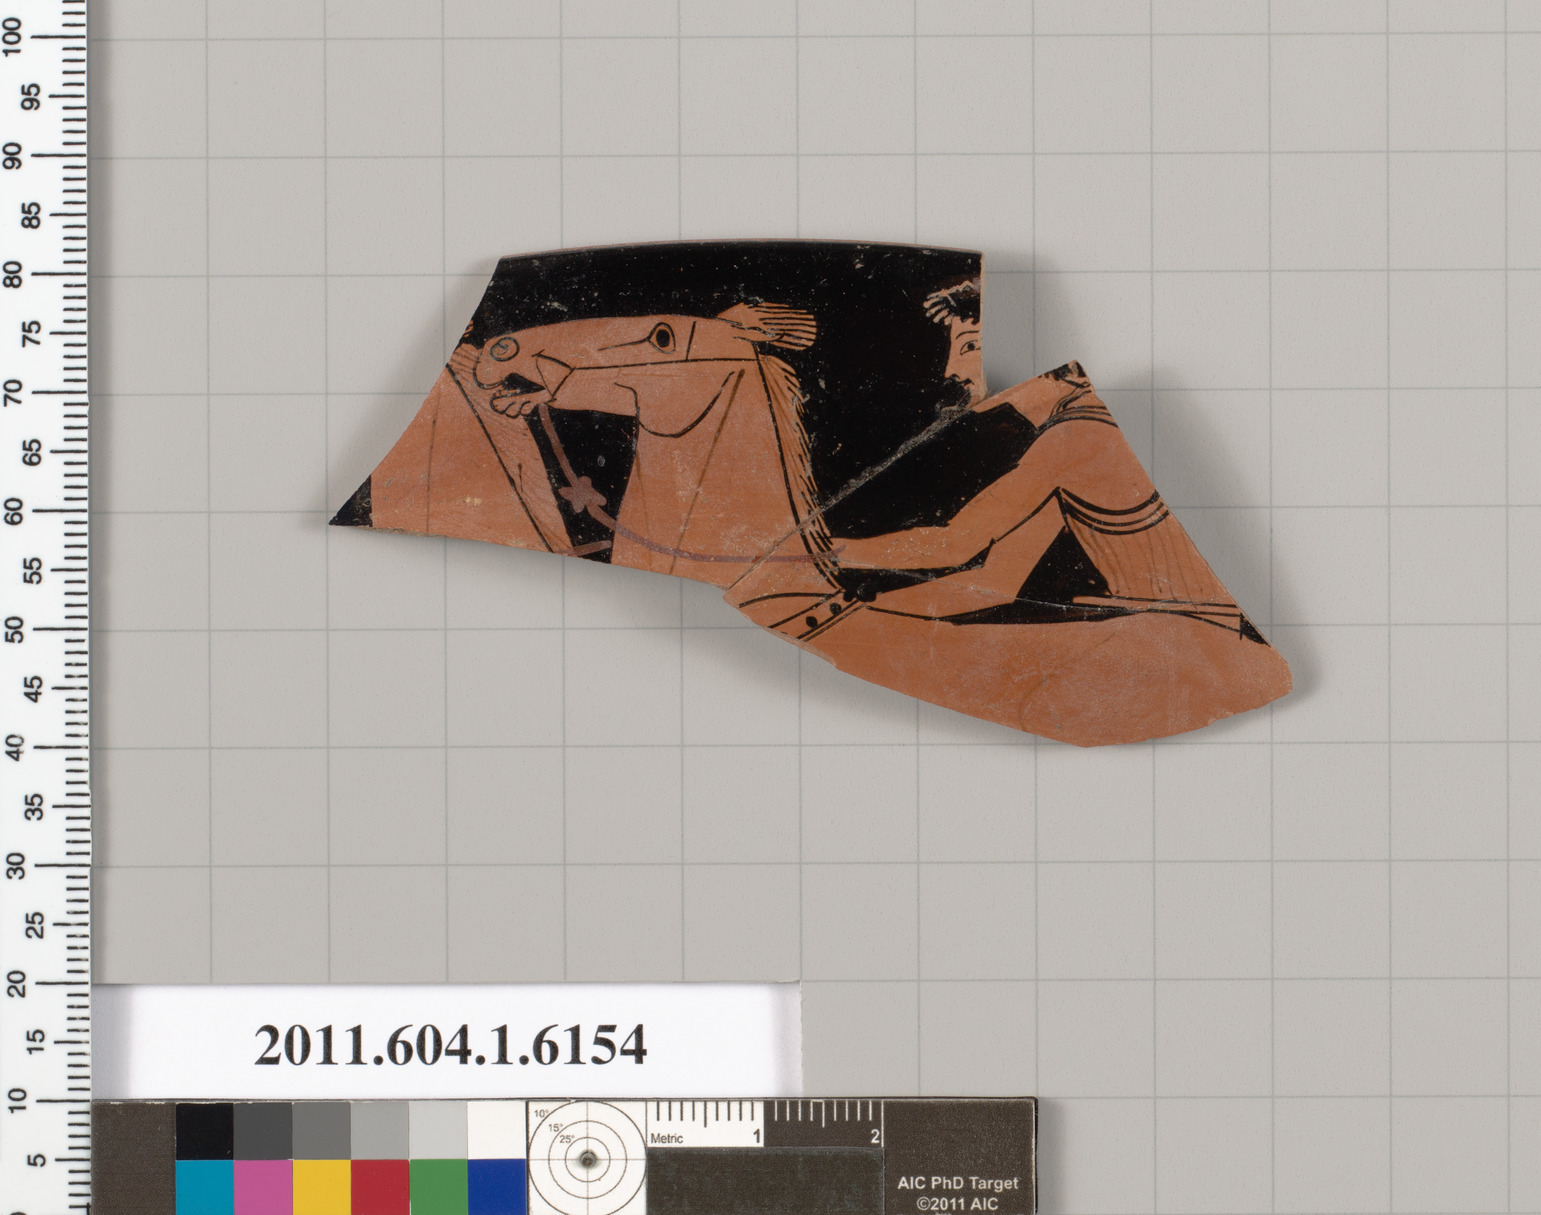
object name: kylix fragment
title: Terracotta rim fragment of a kylix (drinking cup)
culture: greek, attic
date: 520-500 BCE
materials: terracotta